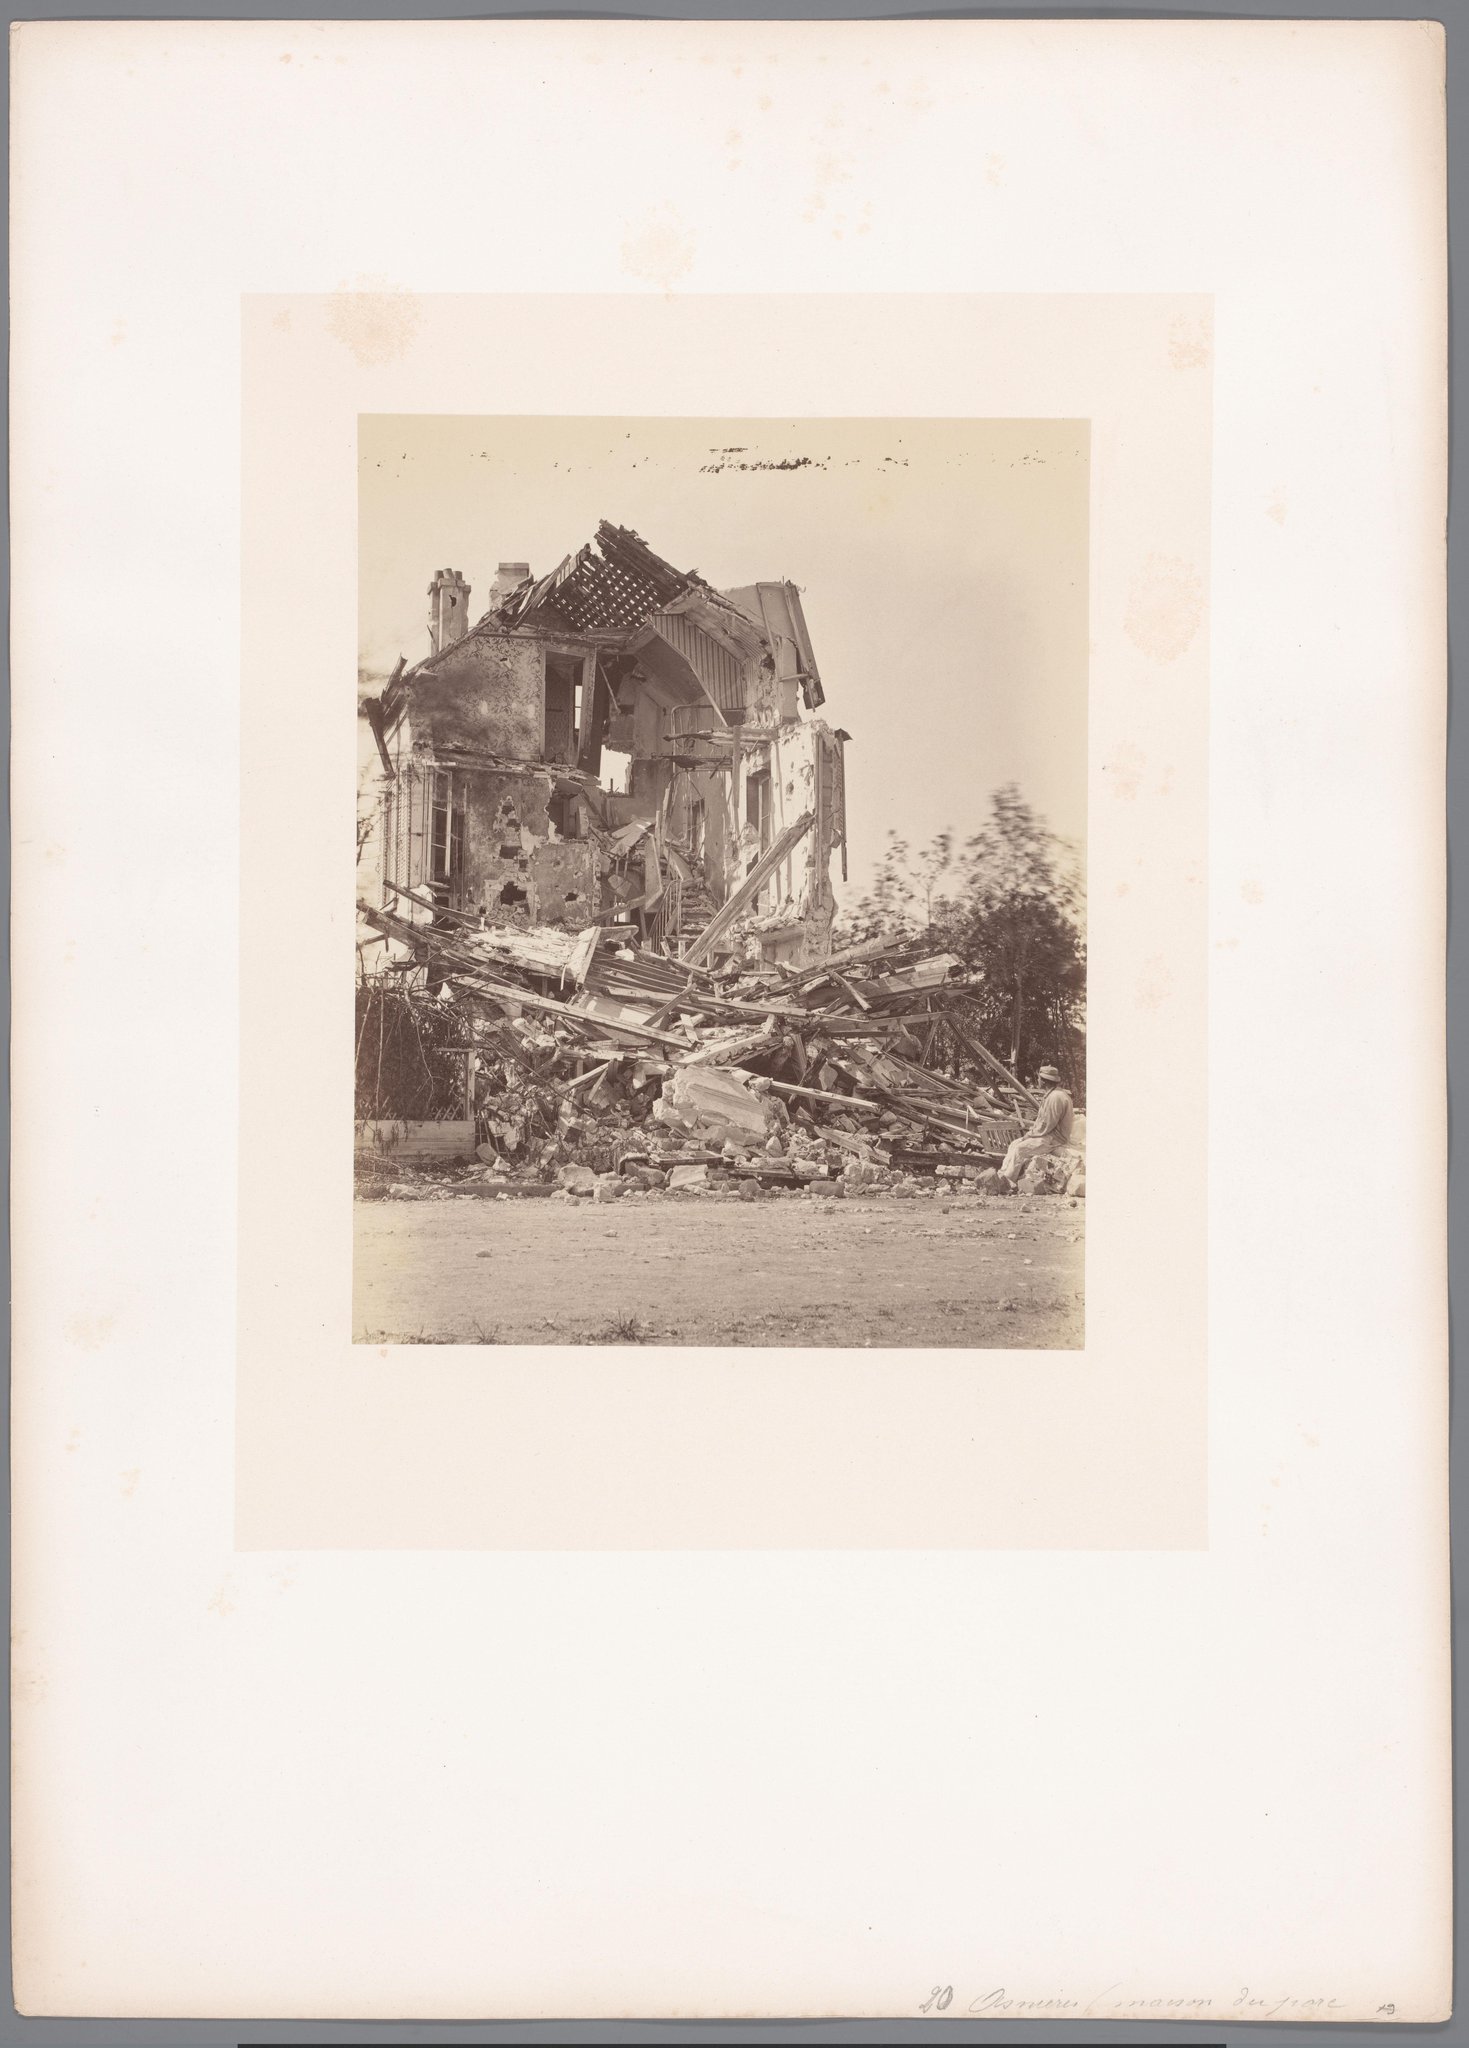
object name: photograph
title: Ruïne van het Maison du Gare, Asnières, Parijs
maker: Anonymous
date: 1871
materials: paper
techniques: albumen print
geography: france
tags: devastated, ruined place or city (~ warfare), paris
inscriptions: title: ‘20 Asnières (maison du gare)’, signature: ‘GOUPIL & CIE’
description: Het Maison du Gare werd verwoest tijdens de Commune-opstand.